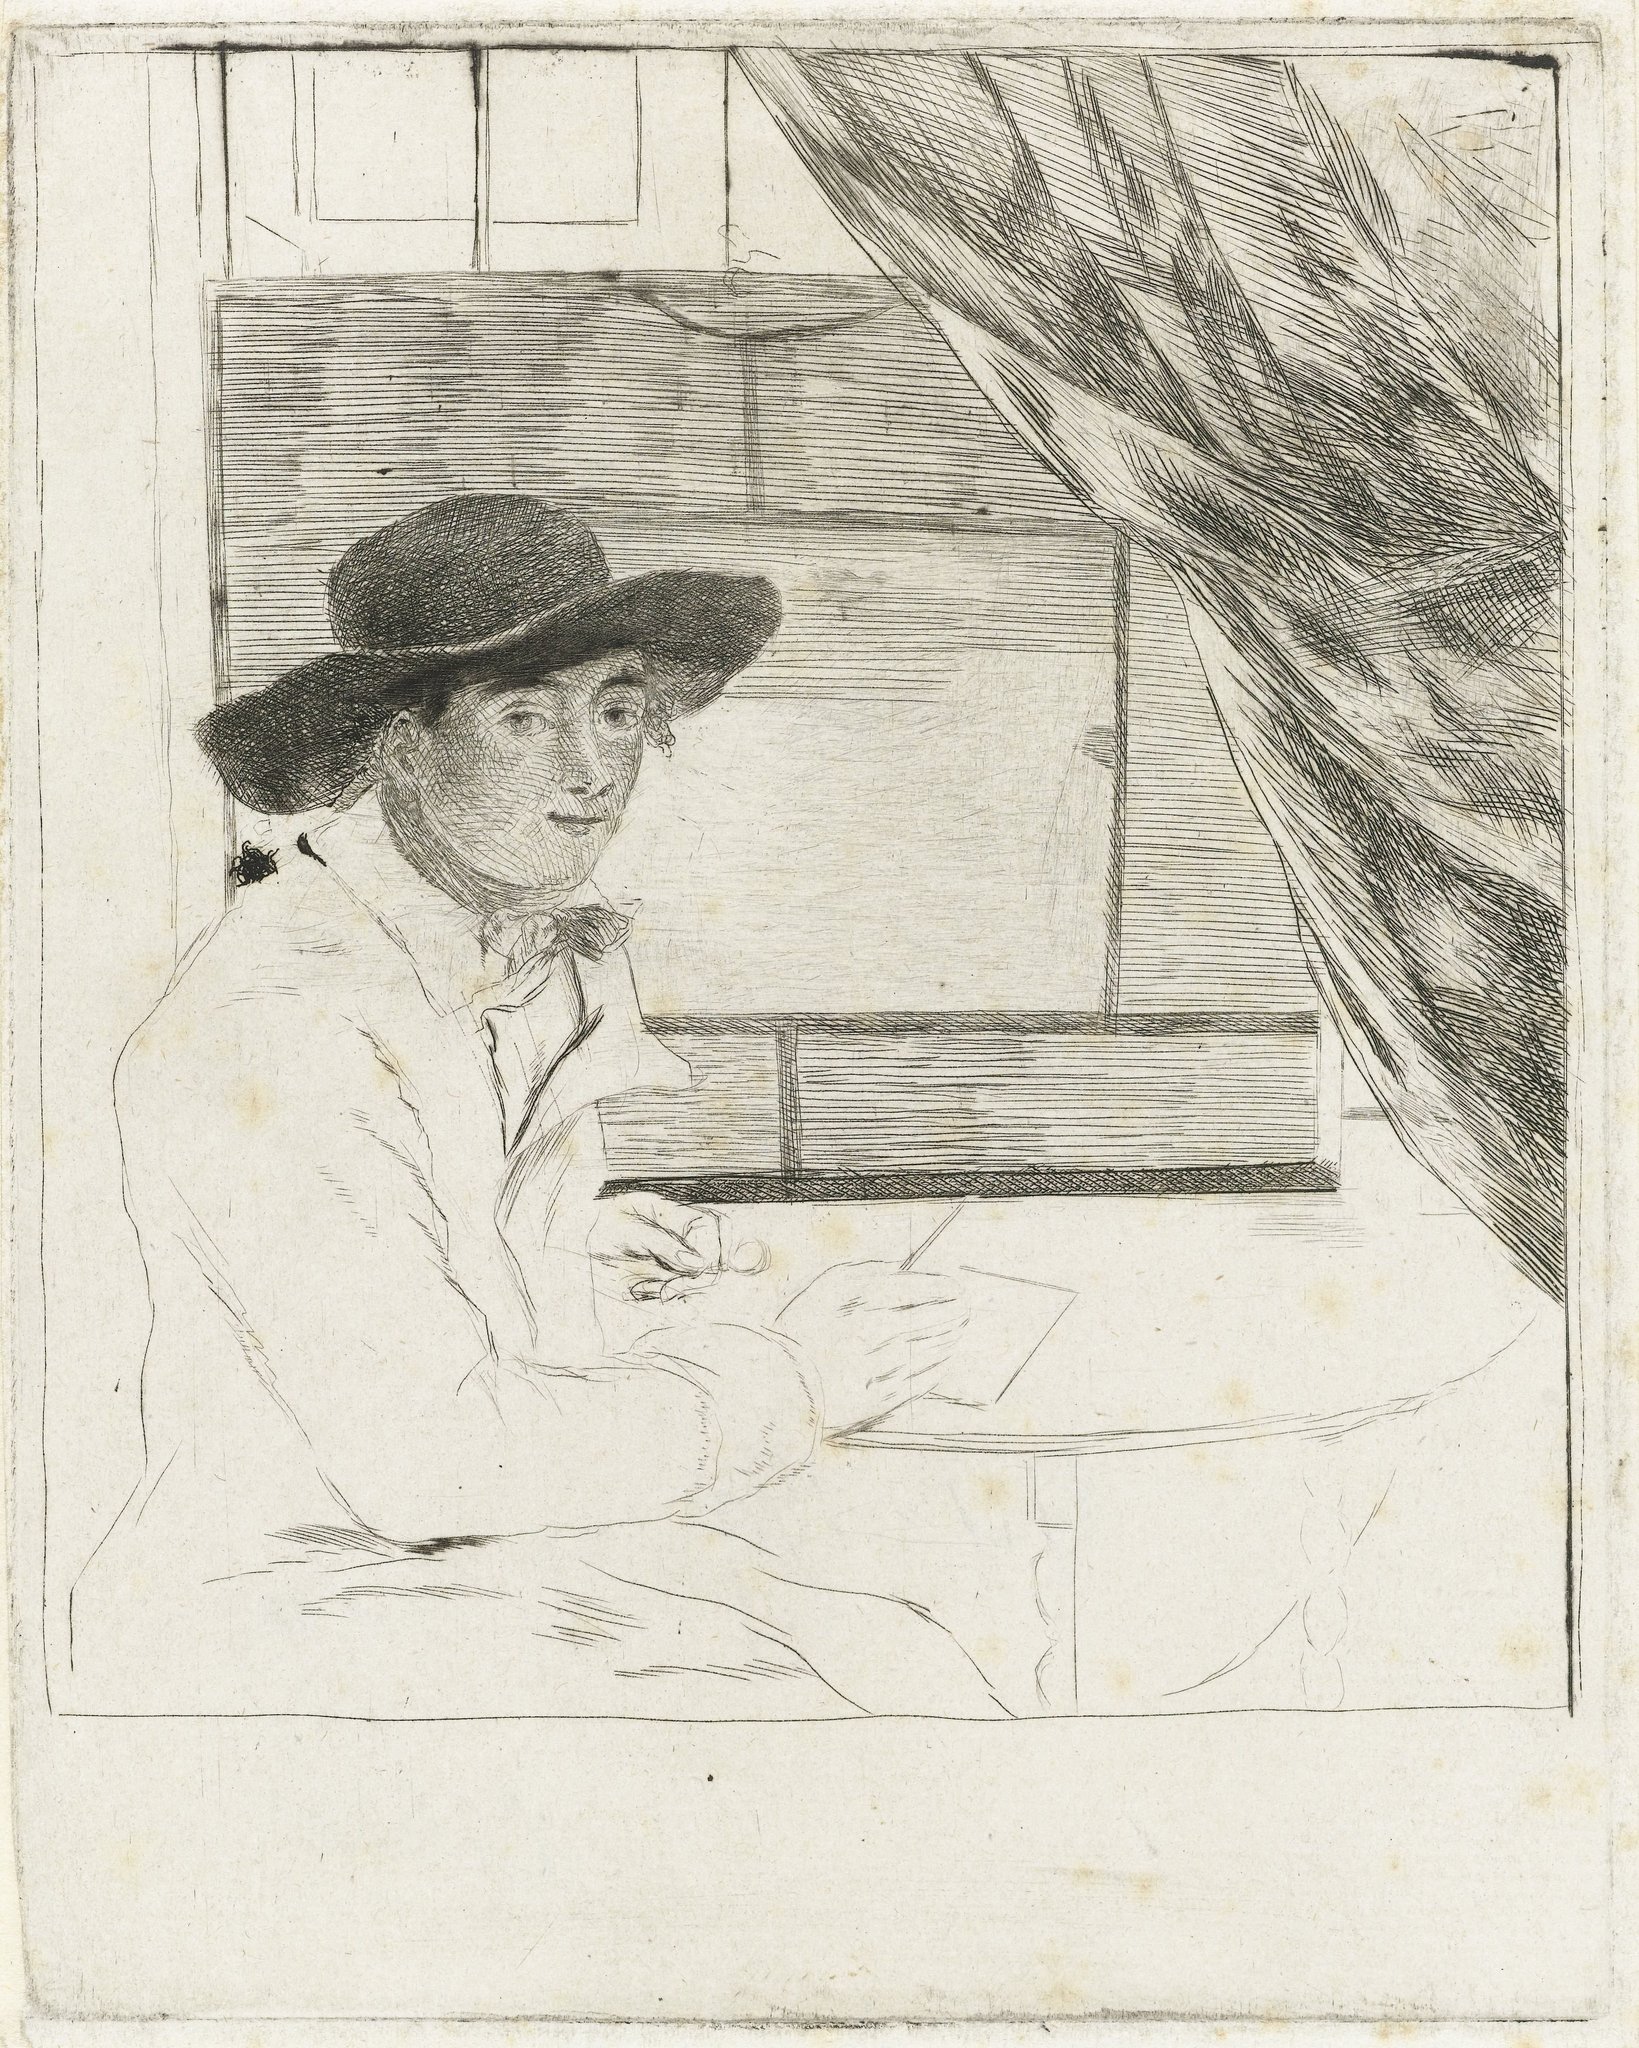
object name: print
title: Portret van een jonge etser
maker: louis bernard coclers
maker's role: draughtsman, print maker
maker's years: 1741-1817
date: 1756-1817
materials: paper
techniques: drypoint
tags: engraver, etcher (+ artist at work)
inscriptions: collector's mark: Lugt 2228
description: Portret van een jonge man zittend aan een halfronde tafel voor het raam. De man houdt een loepje in zijn linker hand en een etsnaald in de rechter. Op tafel ligt een etsplaat. Tegen het raam staat een bladvituur om het licht tegen te houden en de spiegeling van de gepolijste plaat te voorkomen.